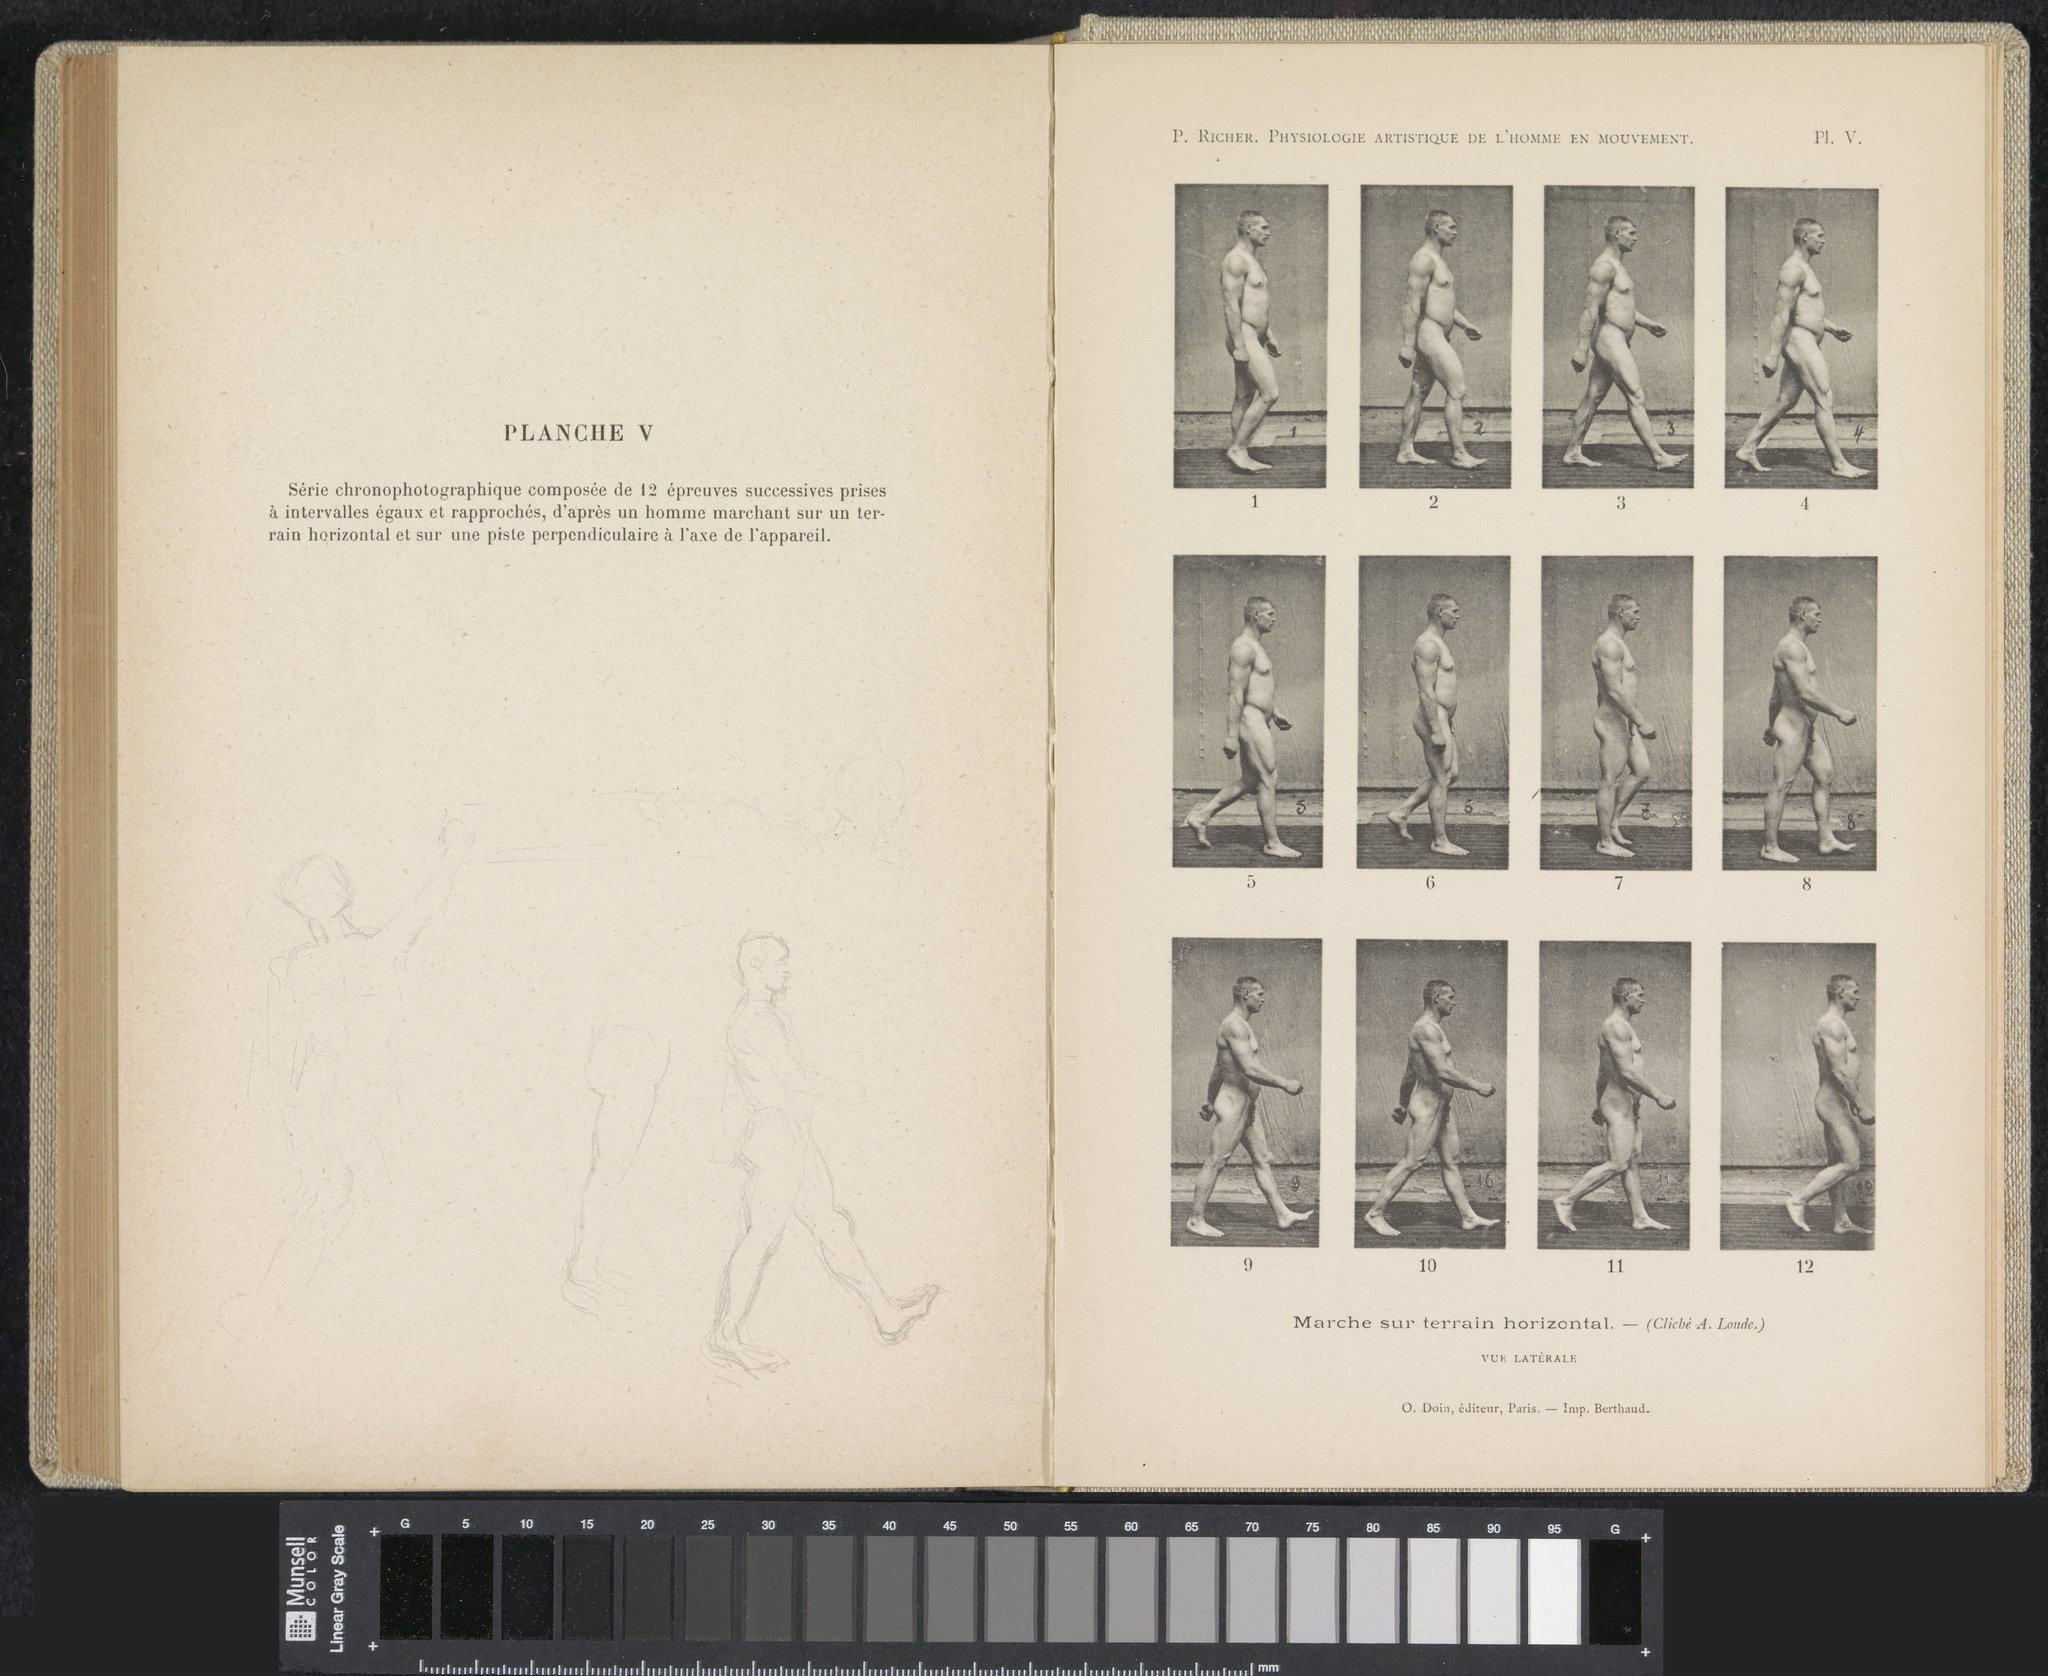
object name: page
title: Naakte, lopende man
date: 1885-1895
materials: paper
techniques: photograph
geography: paris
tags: movements of the human body, walking, man (showing himself) undressed, quasi-nude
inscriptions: number: ‘1 (...) 12’, number: ‘Pl. V.’, inscription: ‘Vue latérale’, number: ‘1 (...) 12’, annotation